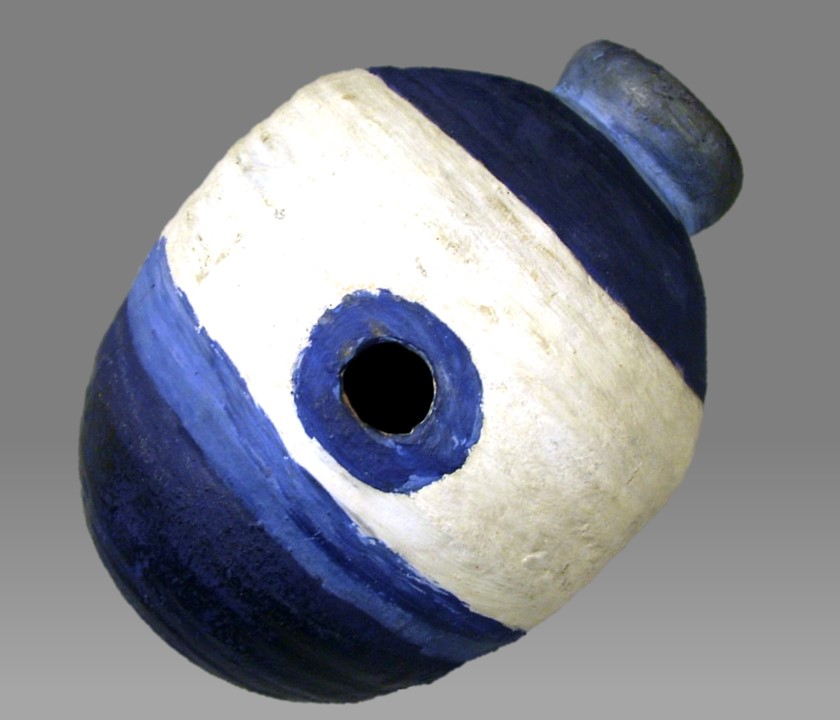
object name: botijuela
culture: west indian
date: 1801-1900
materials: earthenware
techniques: polychrome